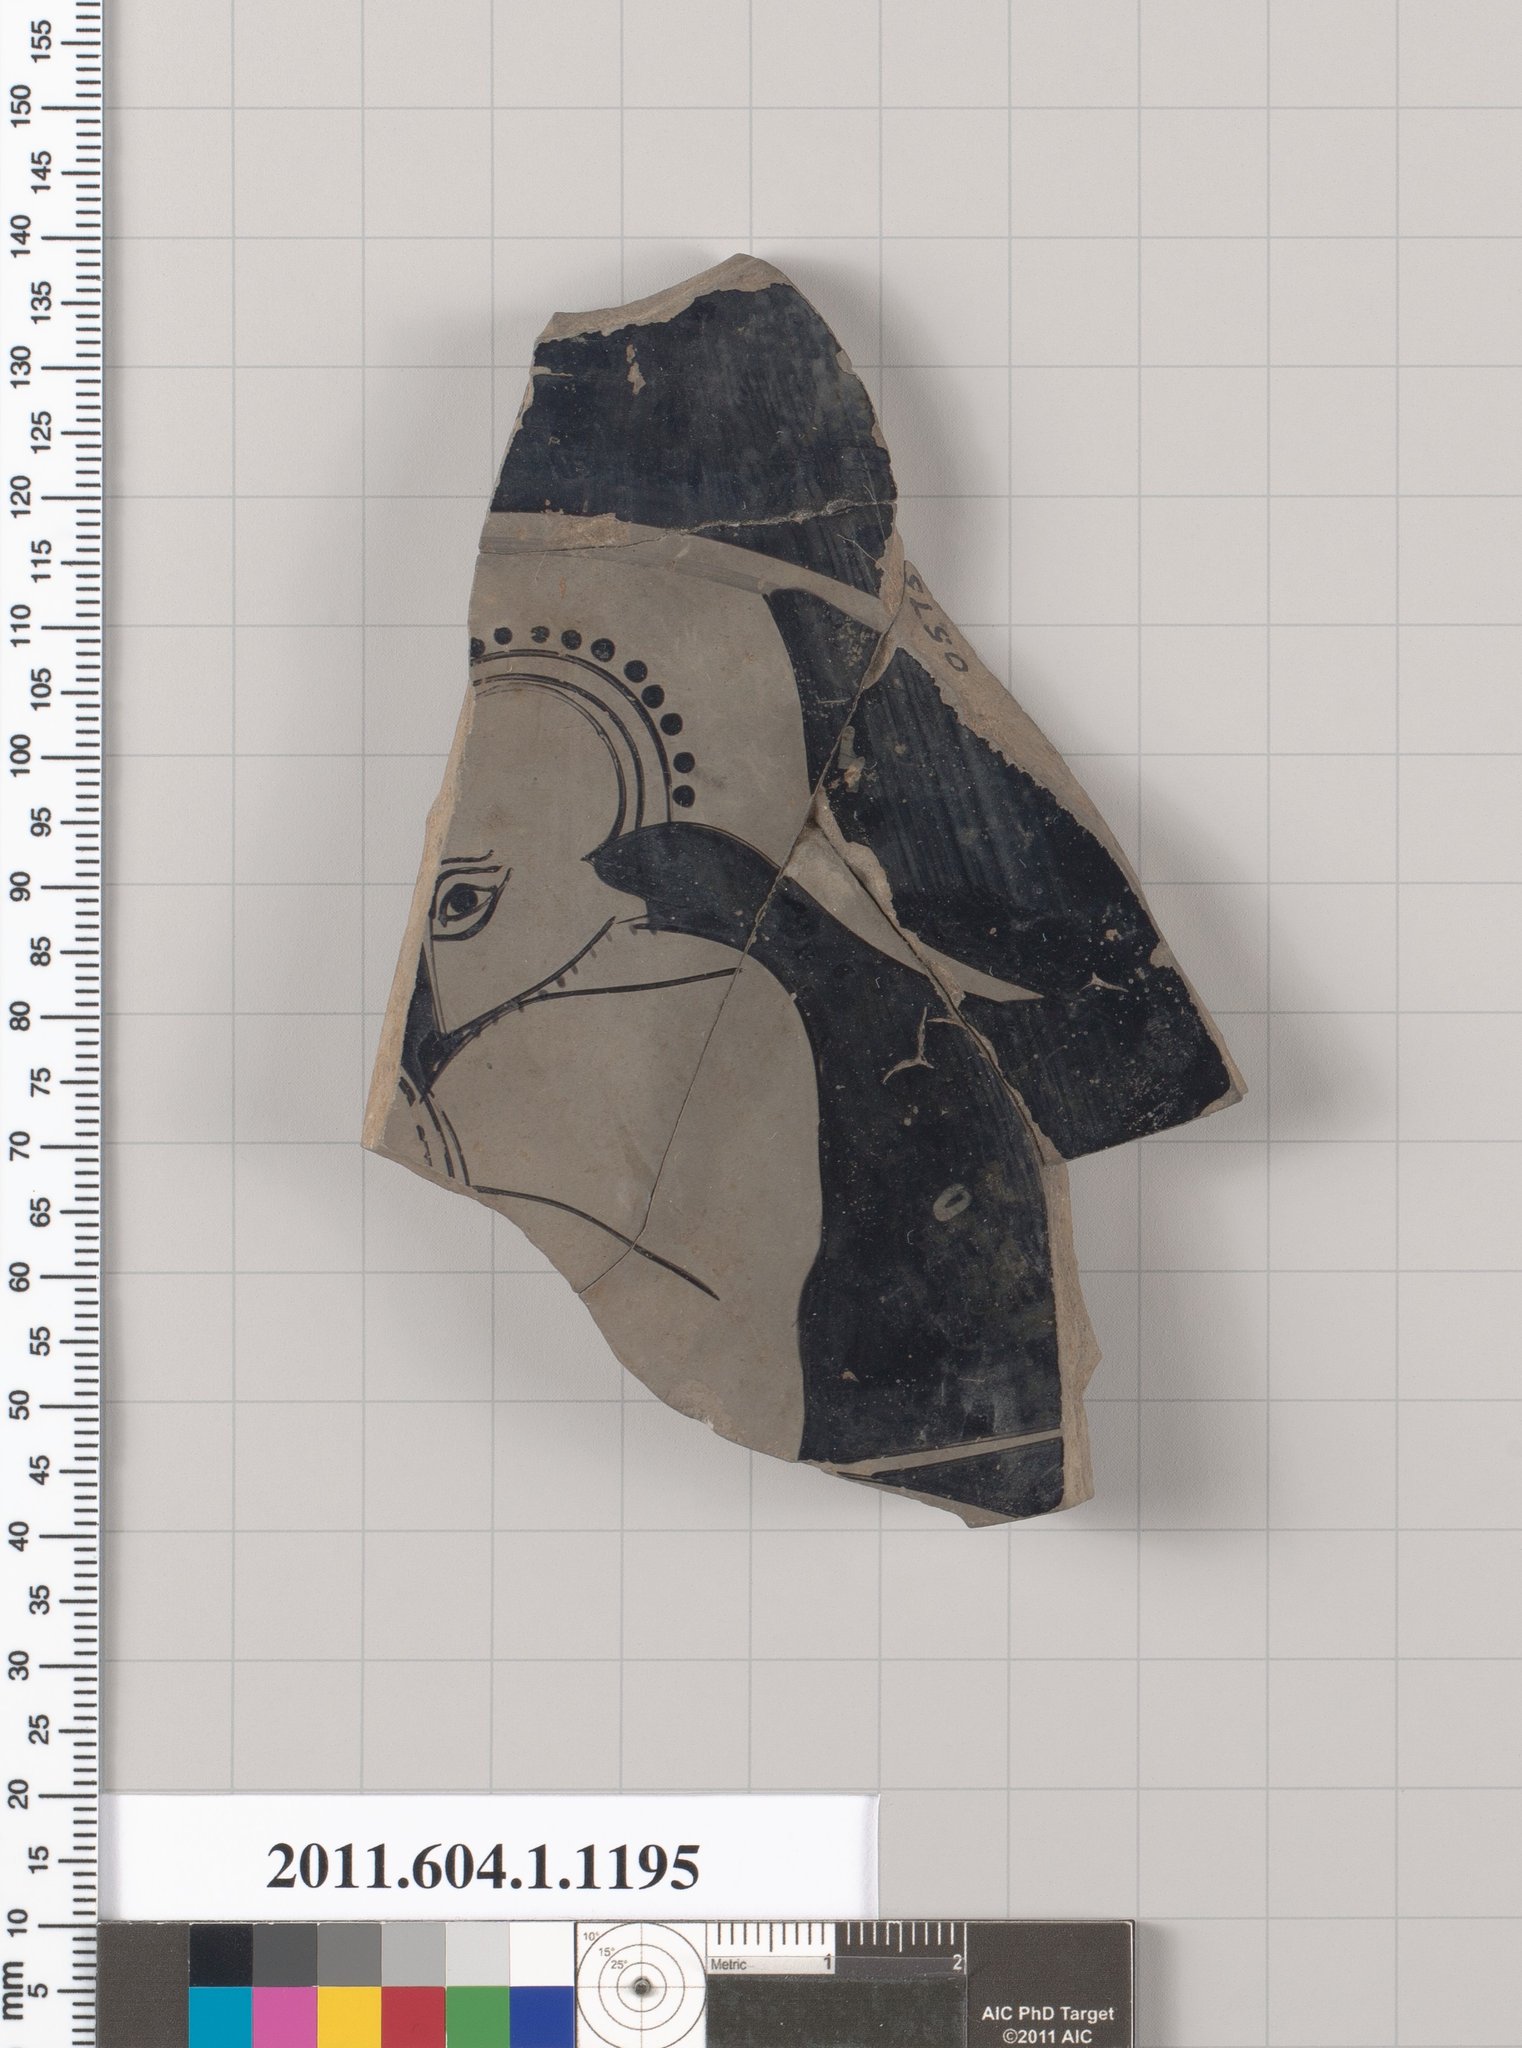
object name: kylix fragment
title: Terracotta fragment of a kylix (drinking cup)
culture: greek, attic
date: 520-500 BCE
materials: terracotta